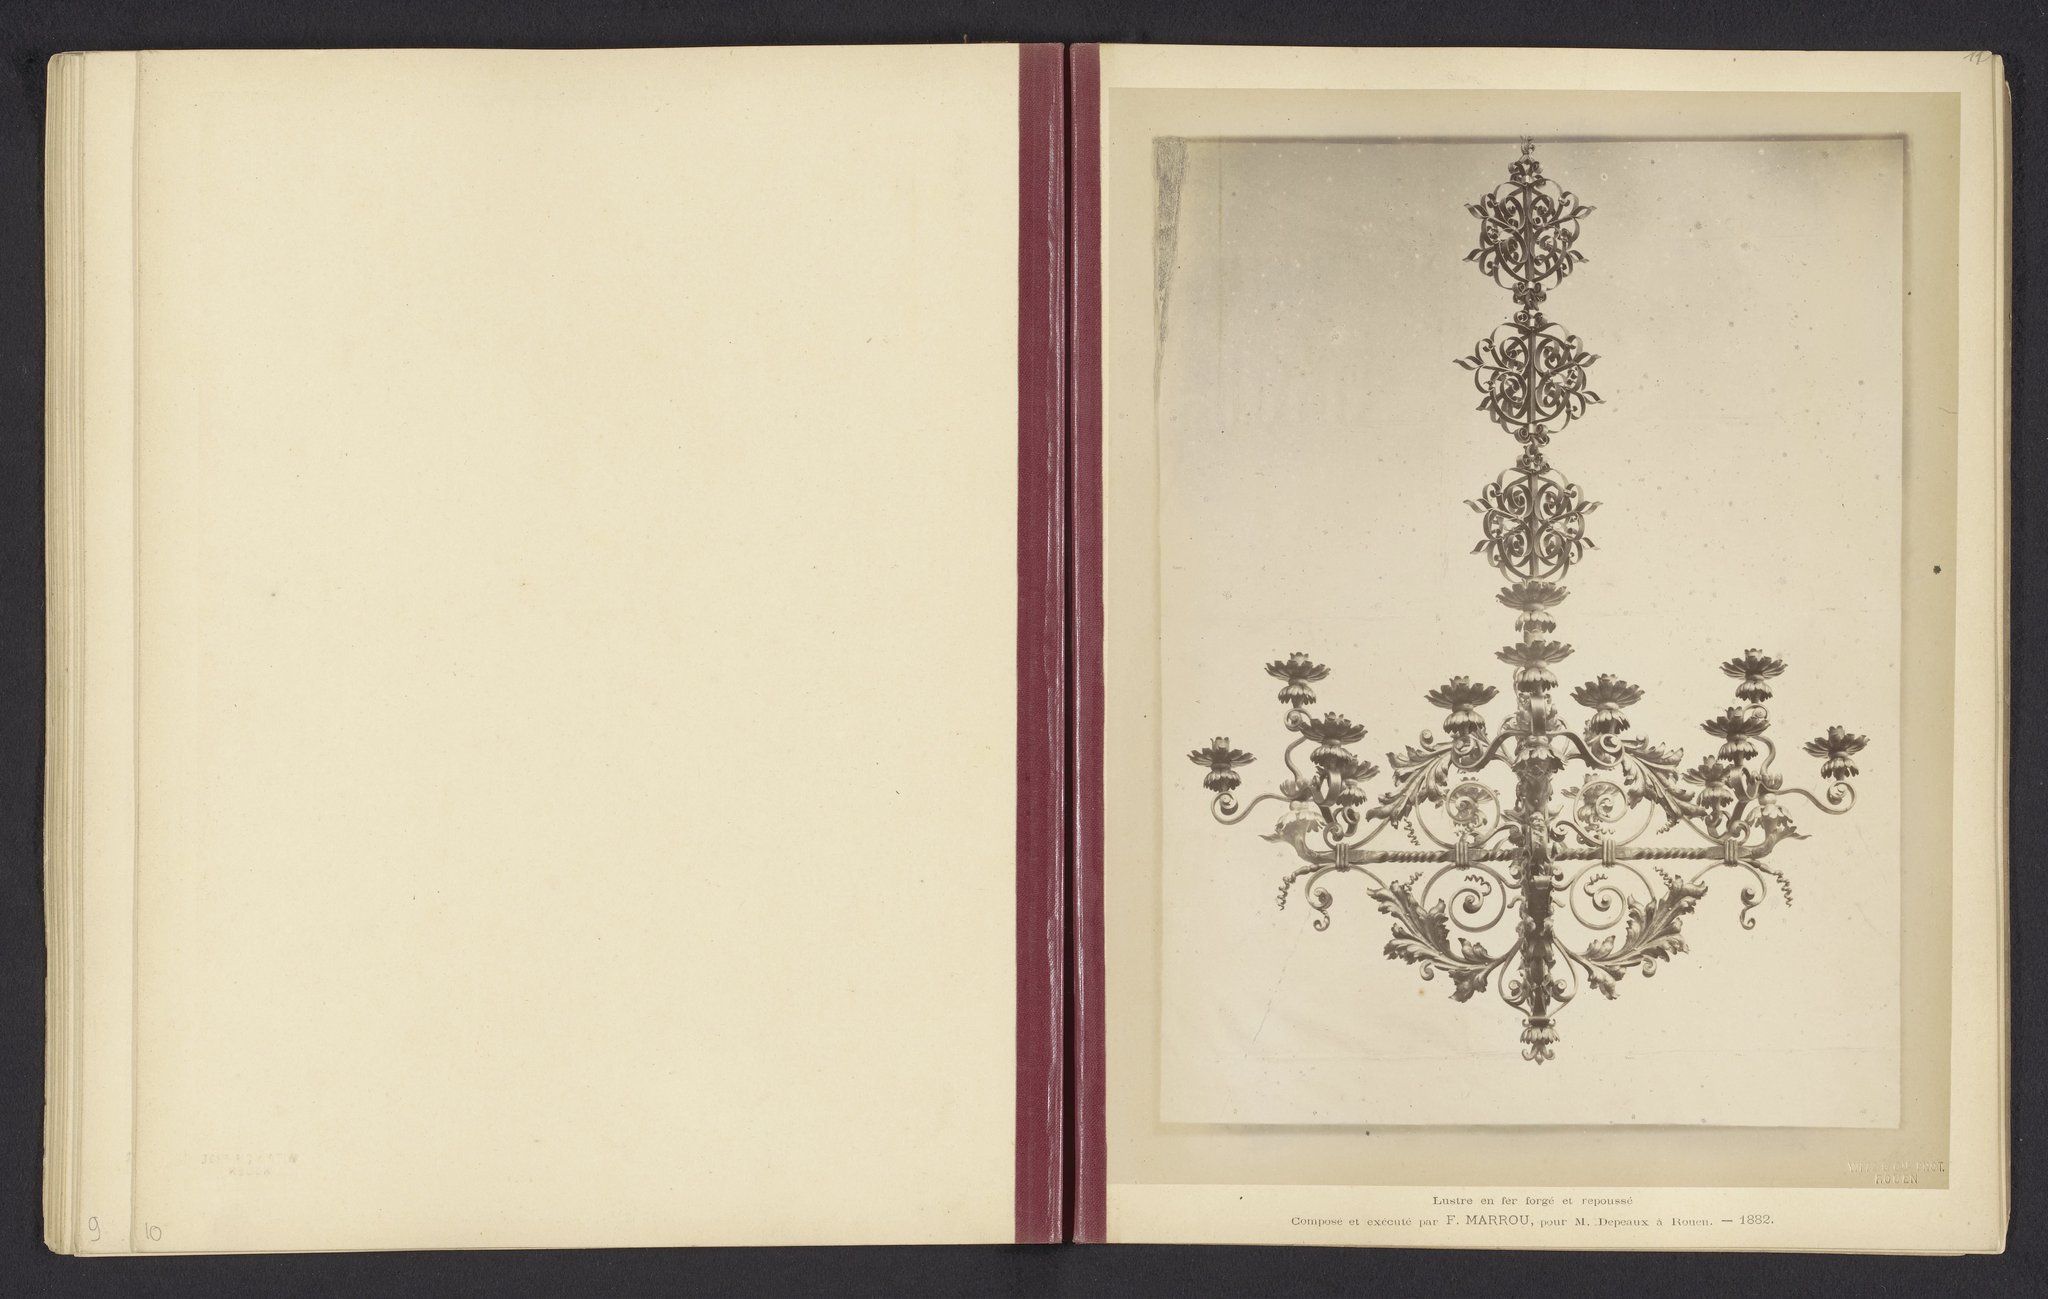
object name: photograph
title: Lustre en fer forgé et repoussé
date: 1882-1884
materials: photographic support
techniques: albumen print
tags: chandelier, candelabrum, ornament derived from plant forms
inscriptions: name: ‘Witz & cie Phot. Rouen’, inscription: ‘Composé et exécuté par F. Marrou, pour M. Depeaux à Rouen.’